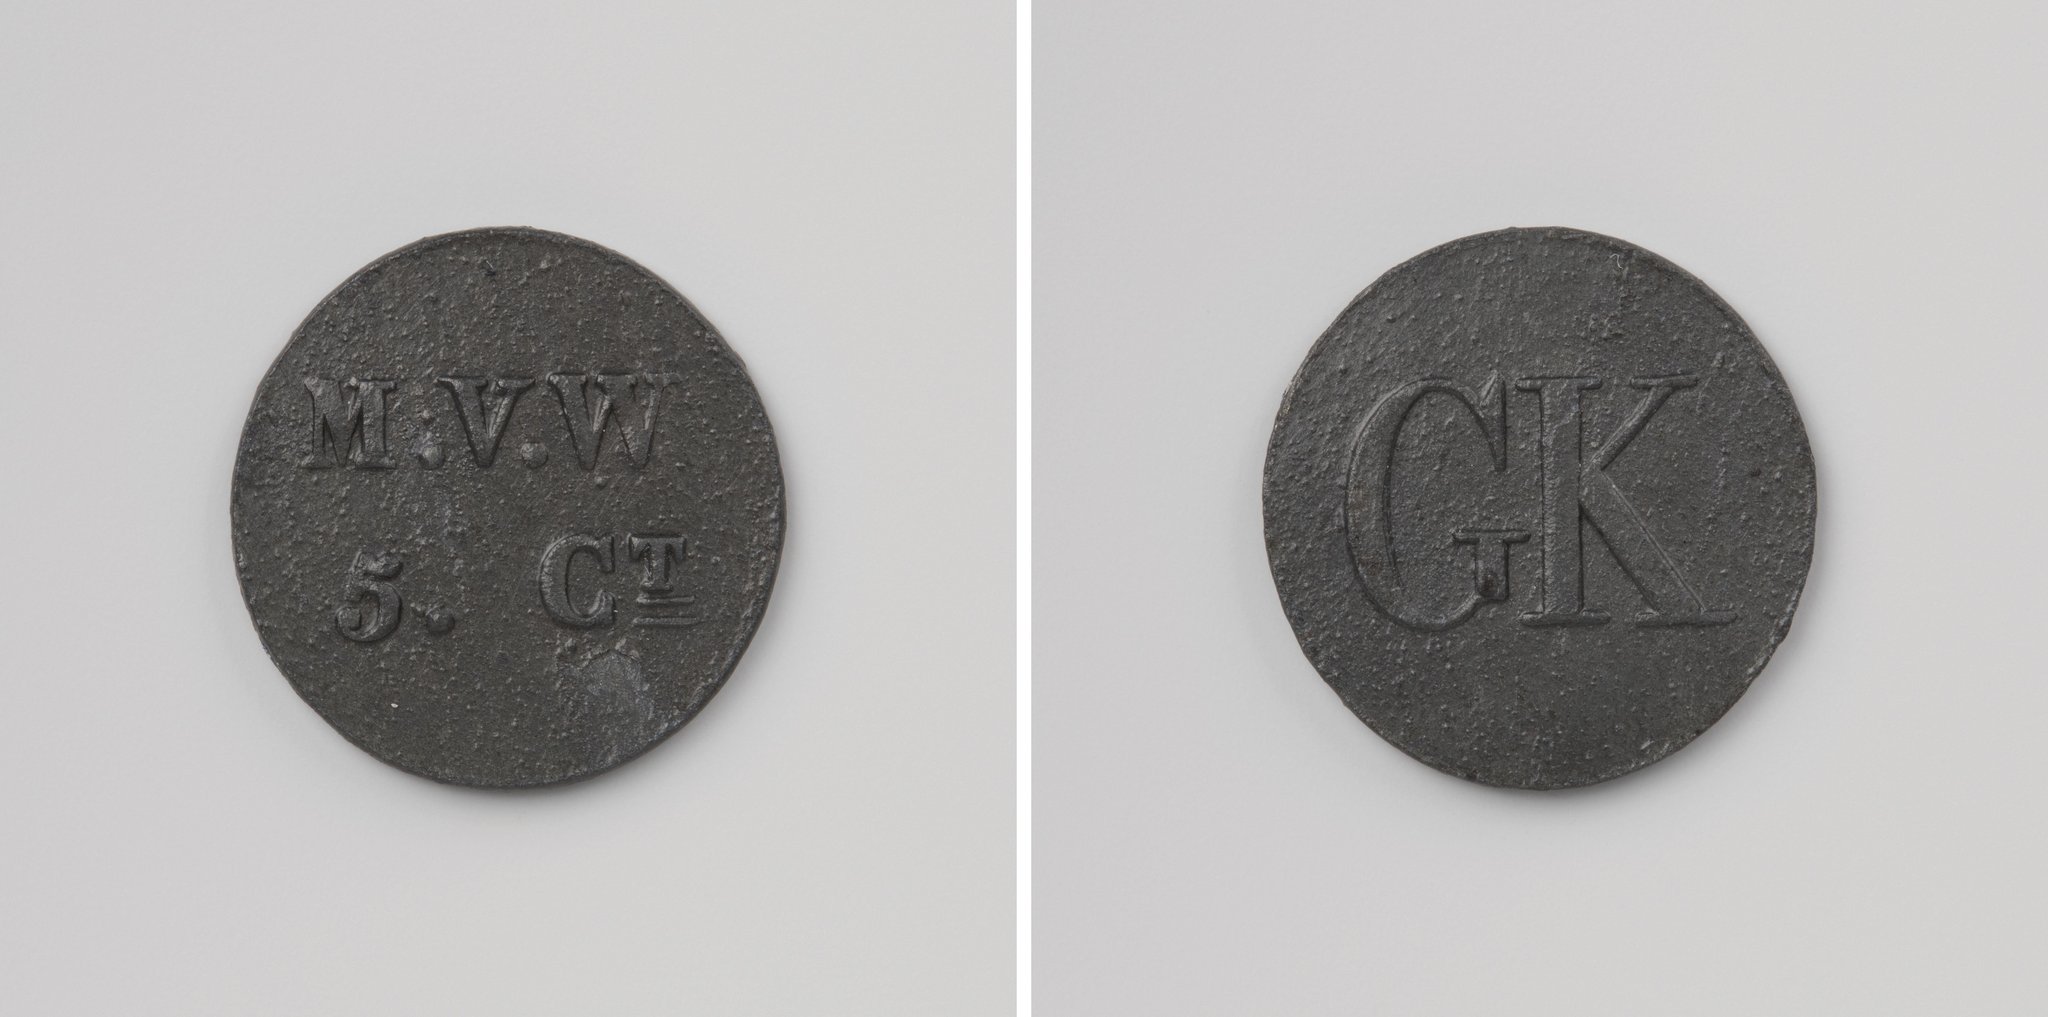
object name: huismunt prison money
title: Huismunt geslagen op last van de Maatschappij van Weldadigheid ter waarde van vijf cent, ten behoeve van de Gewone Koloniën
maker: Anonymous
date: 1818-1859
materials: zinc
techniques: striking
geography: netherlands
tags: maatschappij van weldadigheid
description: Zinken munt. Voorzijde: opschrift boven waardeaanduiding. Keerzijde: opschrift G en K.